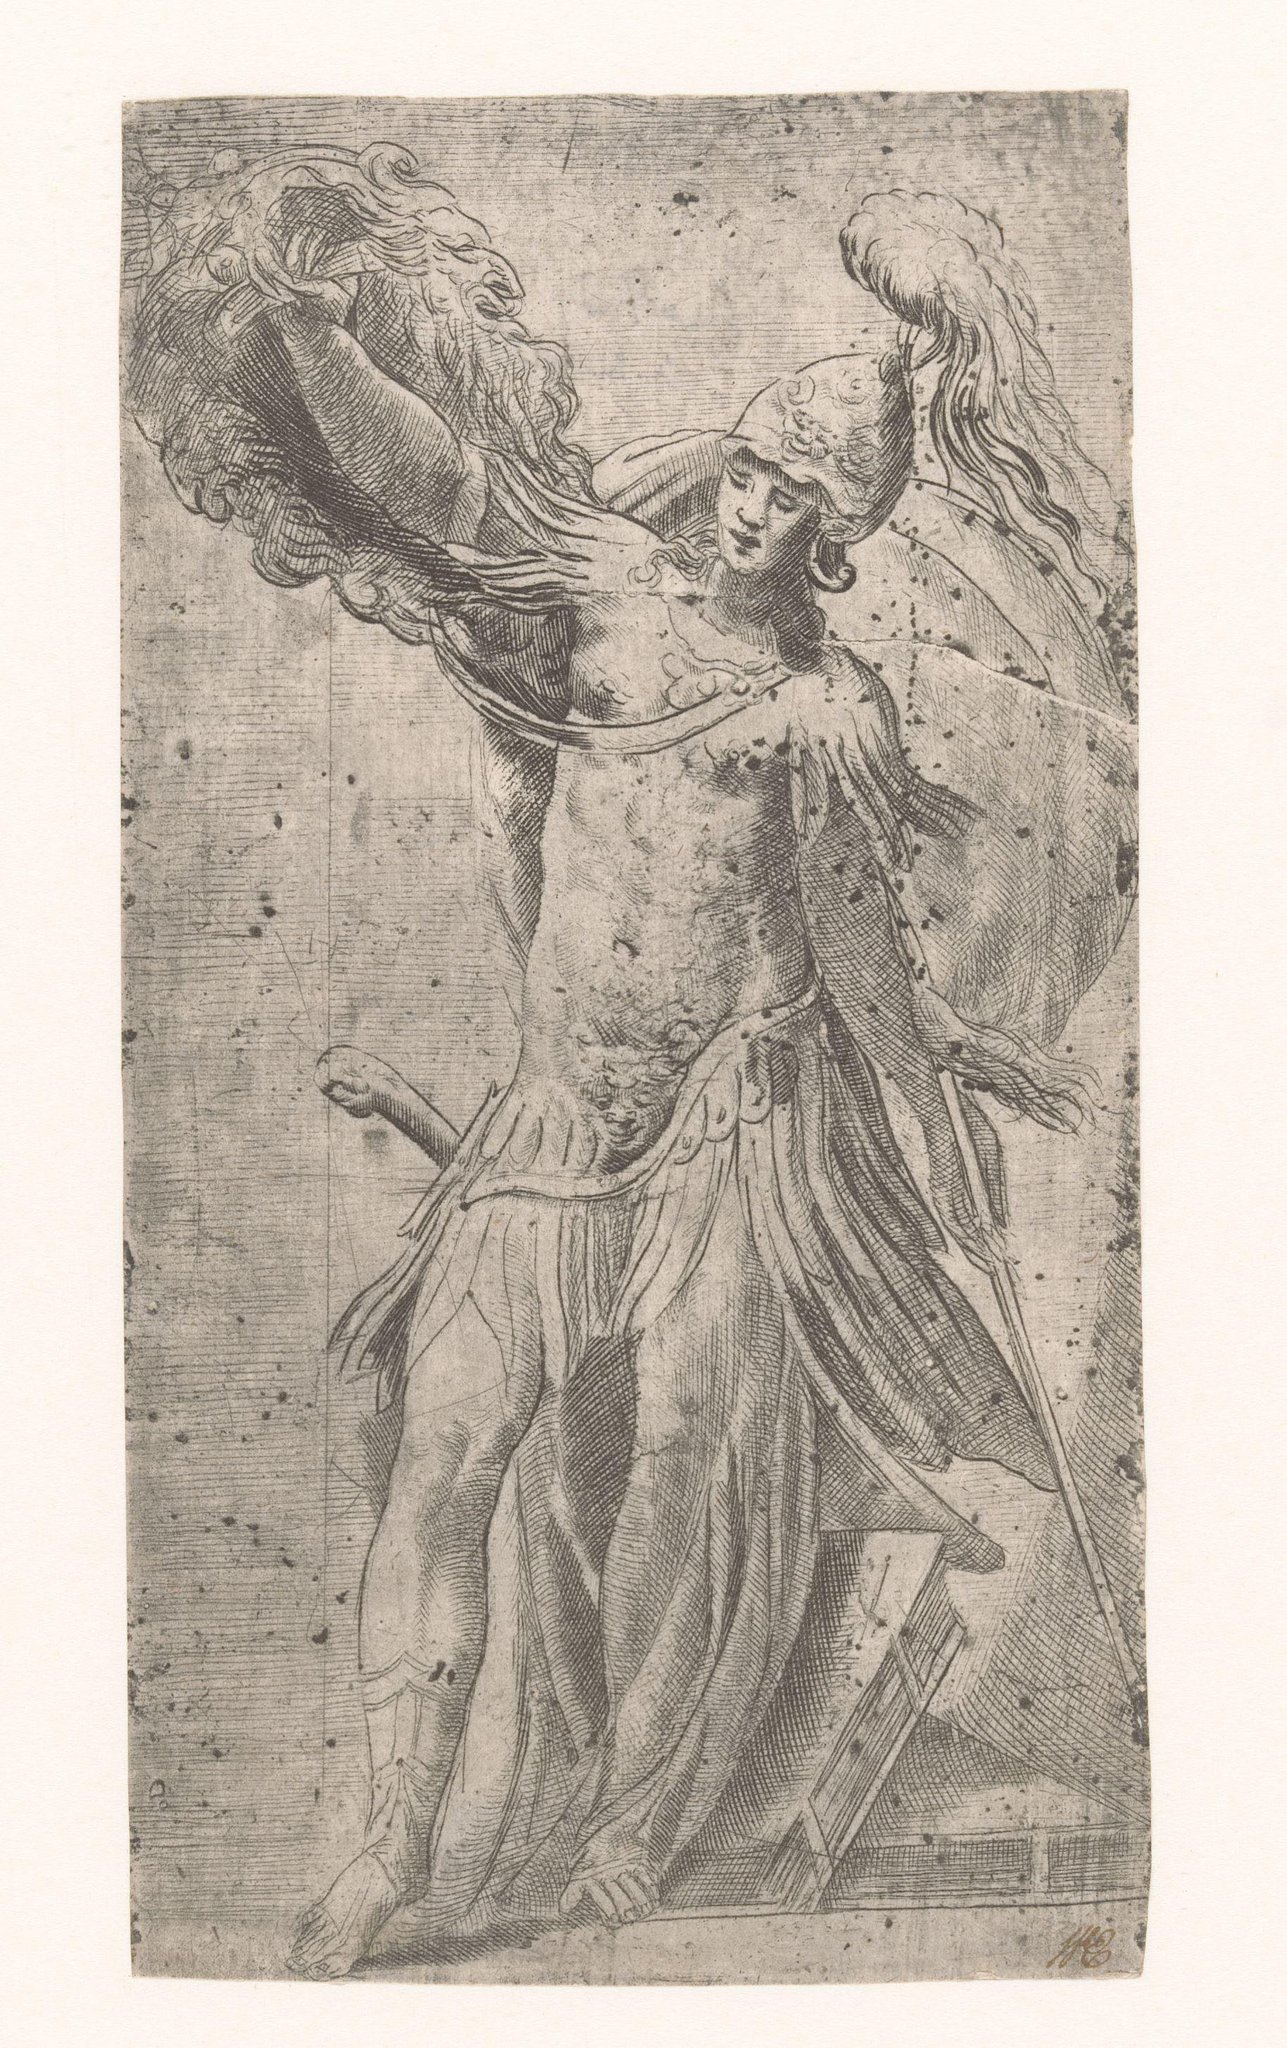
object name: print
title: Bellona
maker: schiavone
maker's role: draughtsman, painter, print maker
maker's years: 1500-1563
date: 1532-1563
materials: paper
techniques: etching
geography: italy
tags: bellona (enyo)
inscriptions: collector's mark: Lugt 2228, inscription: ‘onduidelijk’, inscription: ‘onduidelijk’, collector's mark: Lugt 2760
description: Bellona, de Romeinse godin van de krijgskunst, met schild en speer, staand voor een stapel boeken.